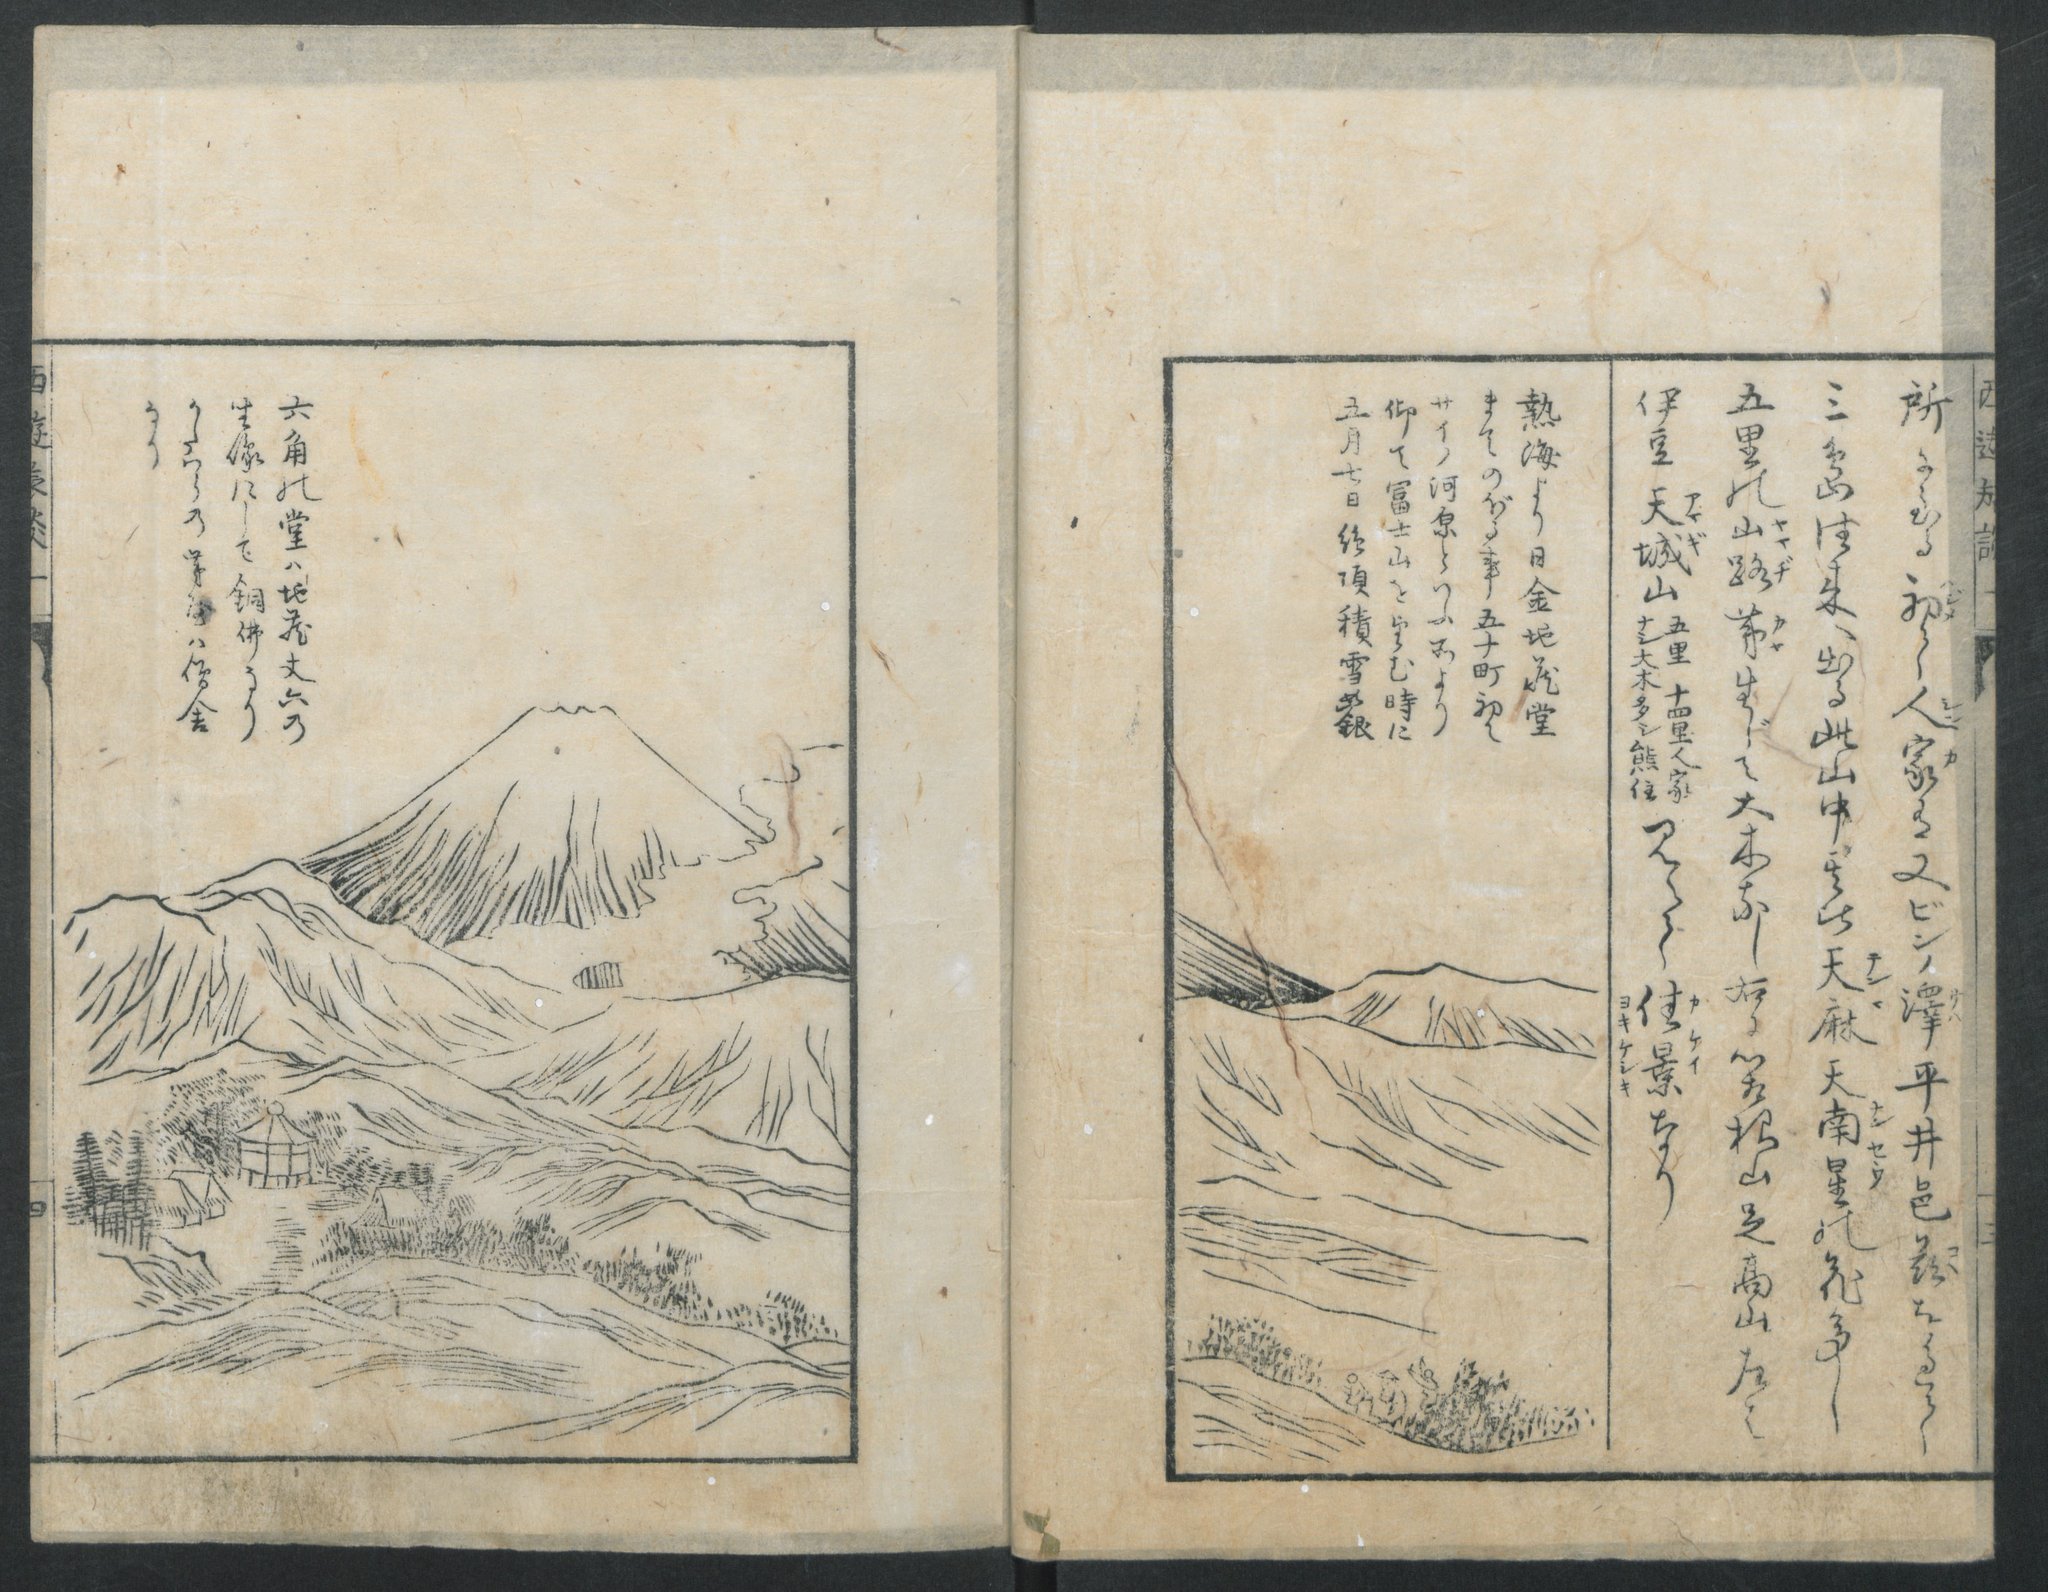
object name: illustrated book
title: A Diary of Travel from Edo to Nagasaki (Seiyūryōdan)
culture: japanese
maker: shiba kōkan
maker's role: artist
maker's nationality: japanese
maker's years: 1747-1818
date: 1803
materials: ink, paper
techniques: woodblock print